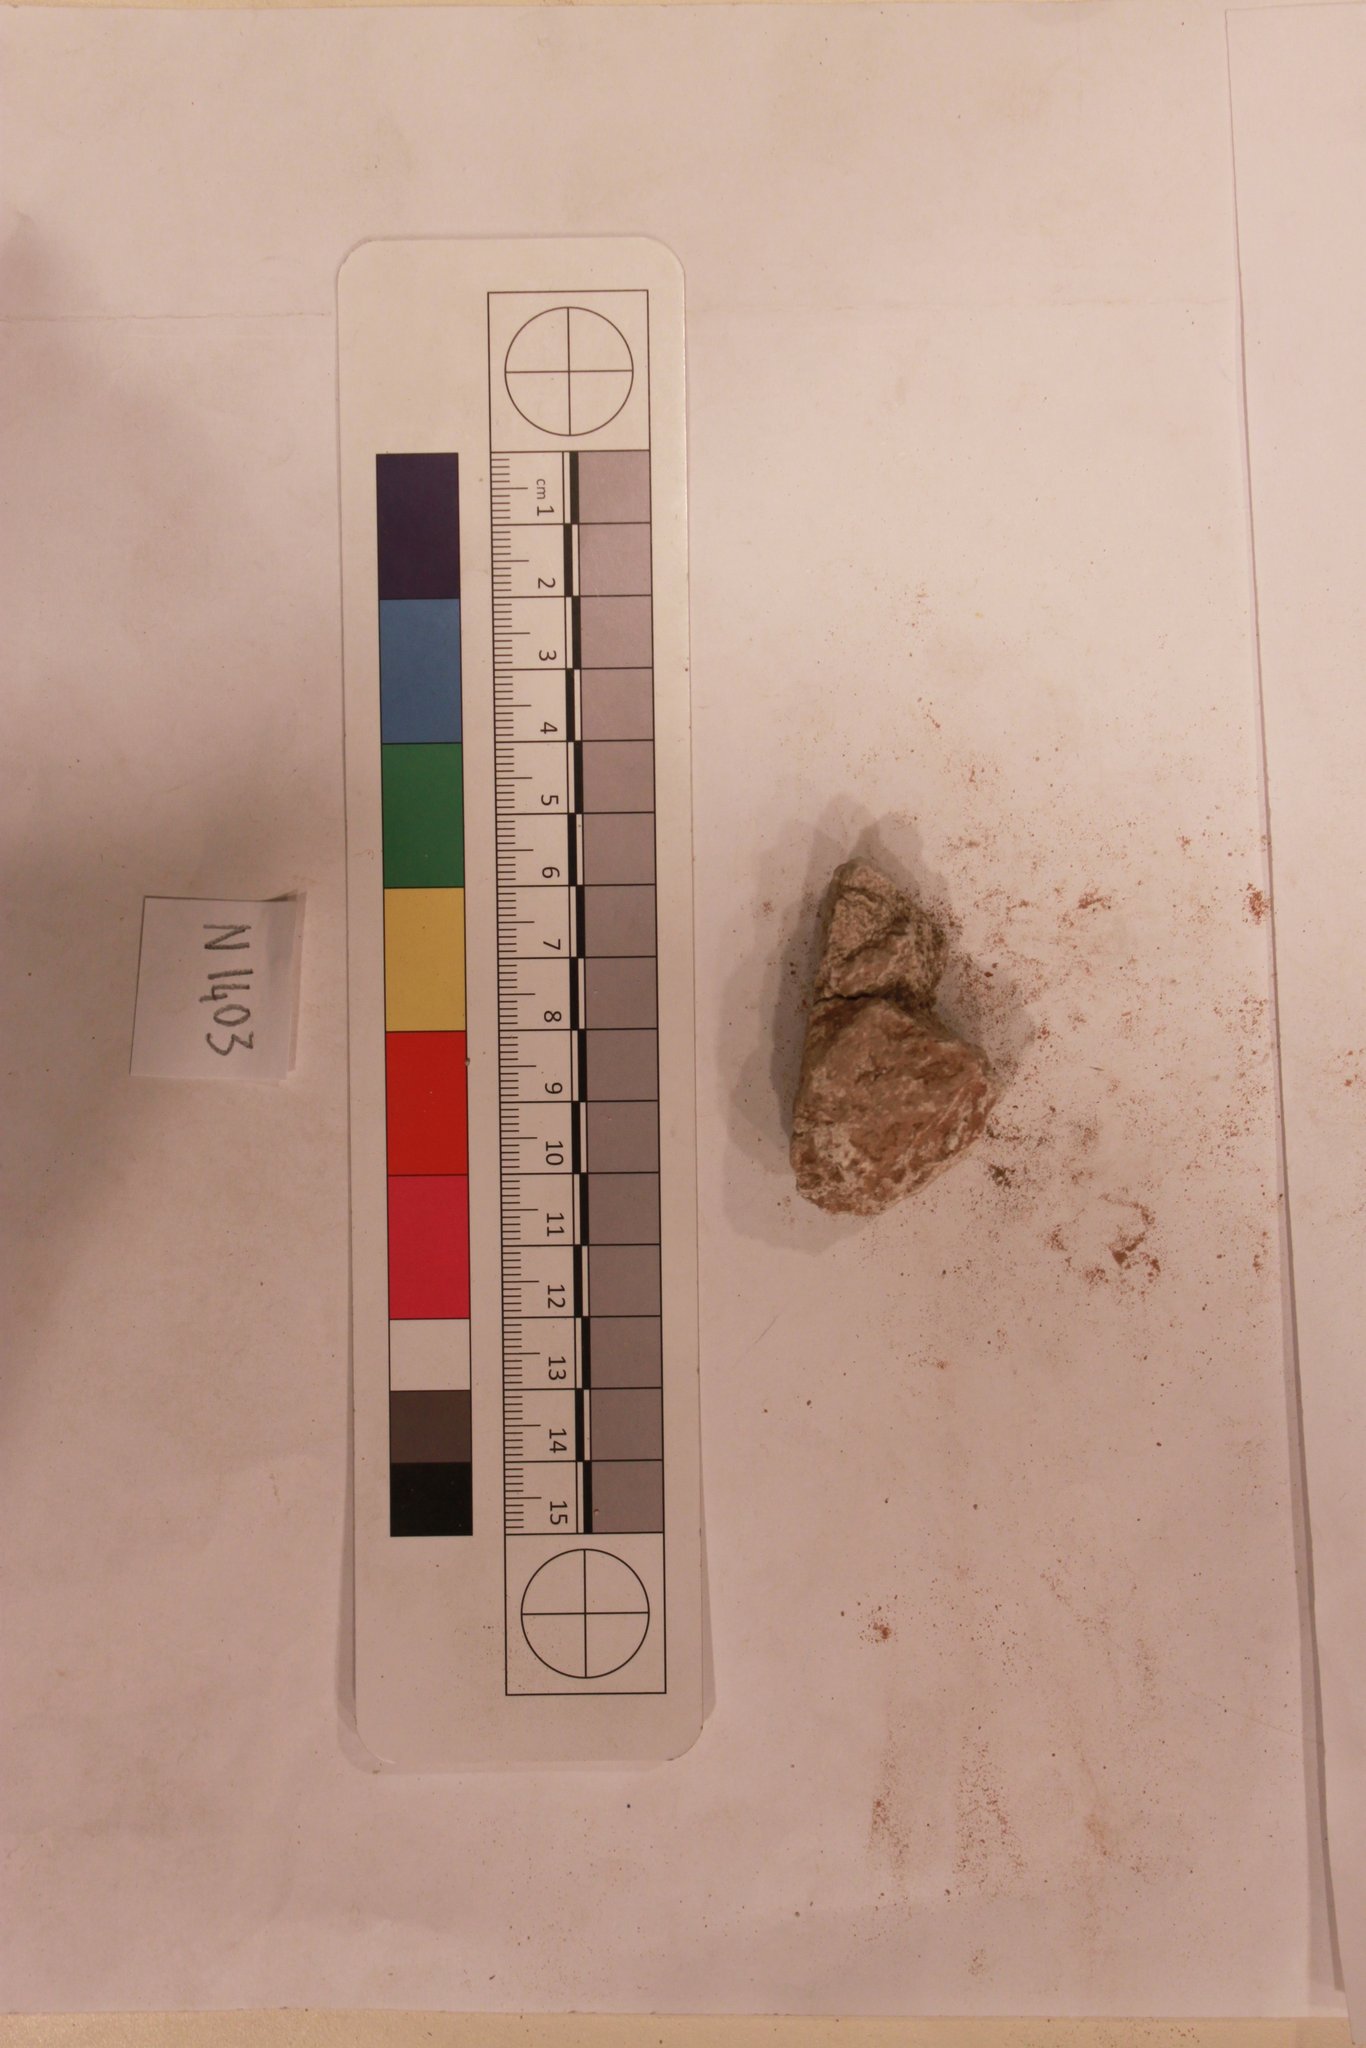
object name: fragment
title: Stucco Fragment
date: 701-1200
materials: plaster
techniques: carving, painting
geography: iran